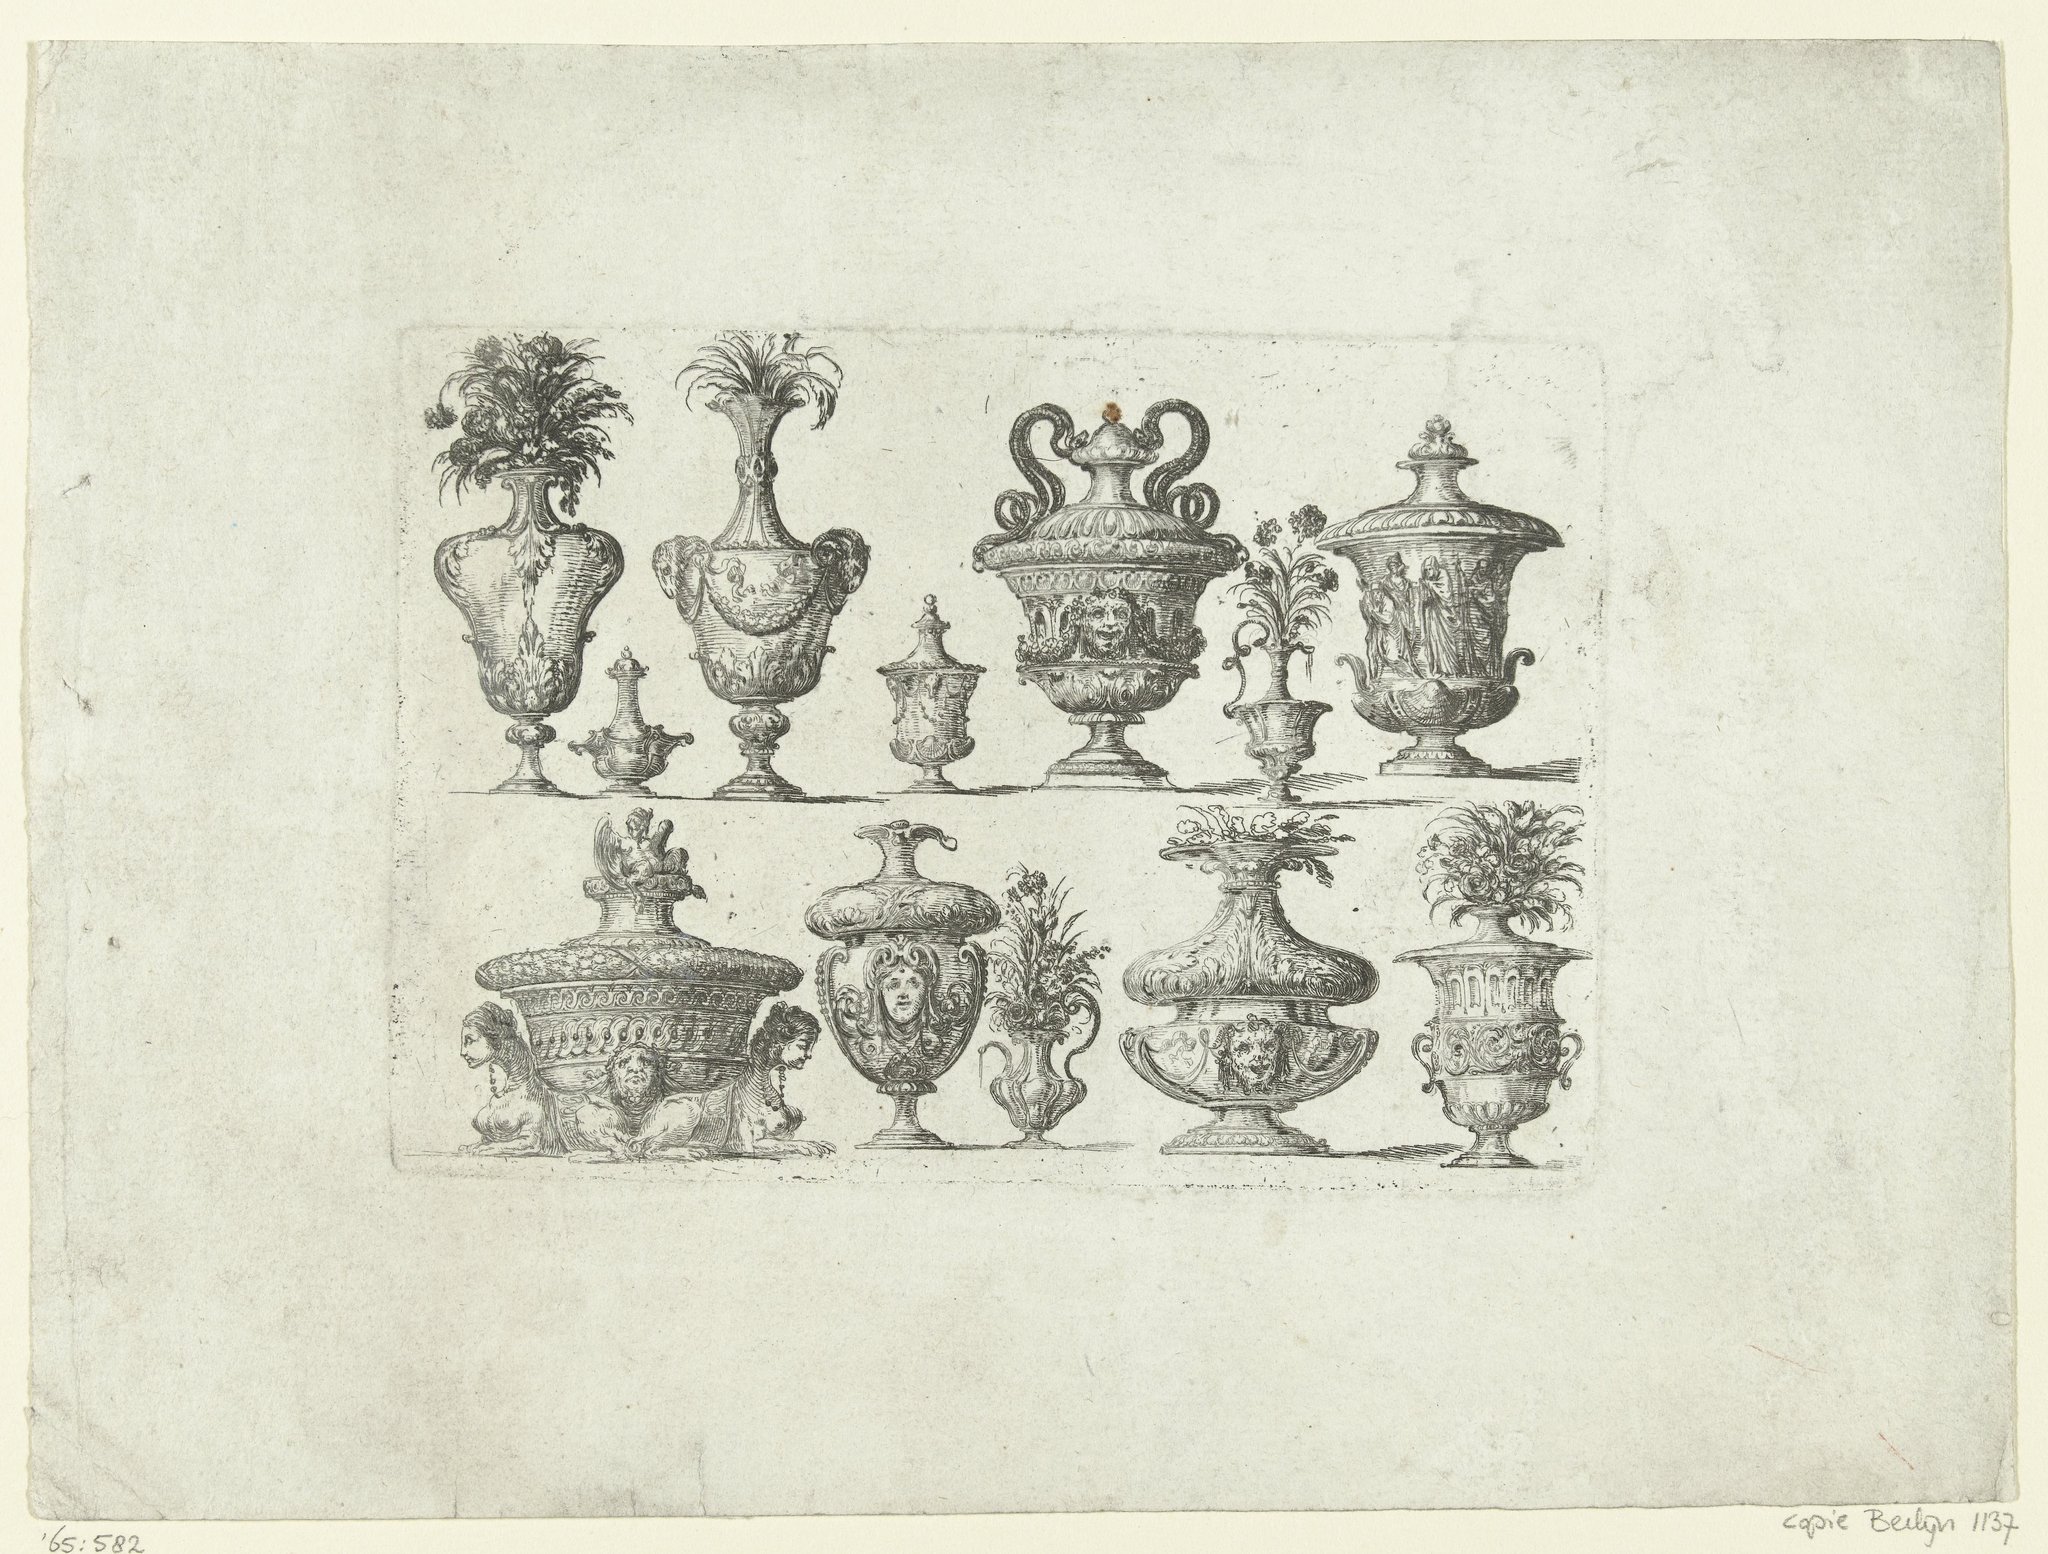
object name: print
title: Vazen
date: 1740-1766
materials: paper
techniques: etching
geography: italy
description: De vazen staan in twee rijen onder elkaar. De vaas linksonder steunt op twee sfinxen.